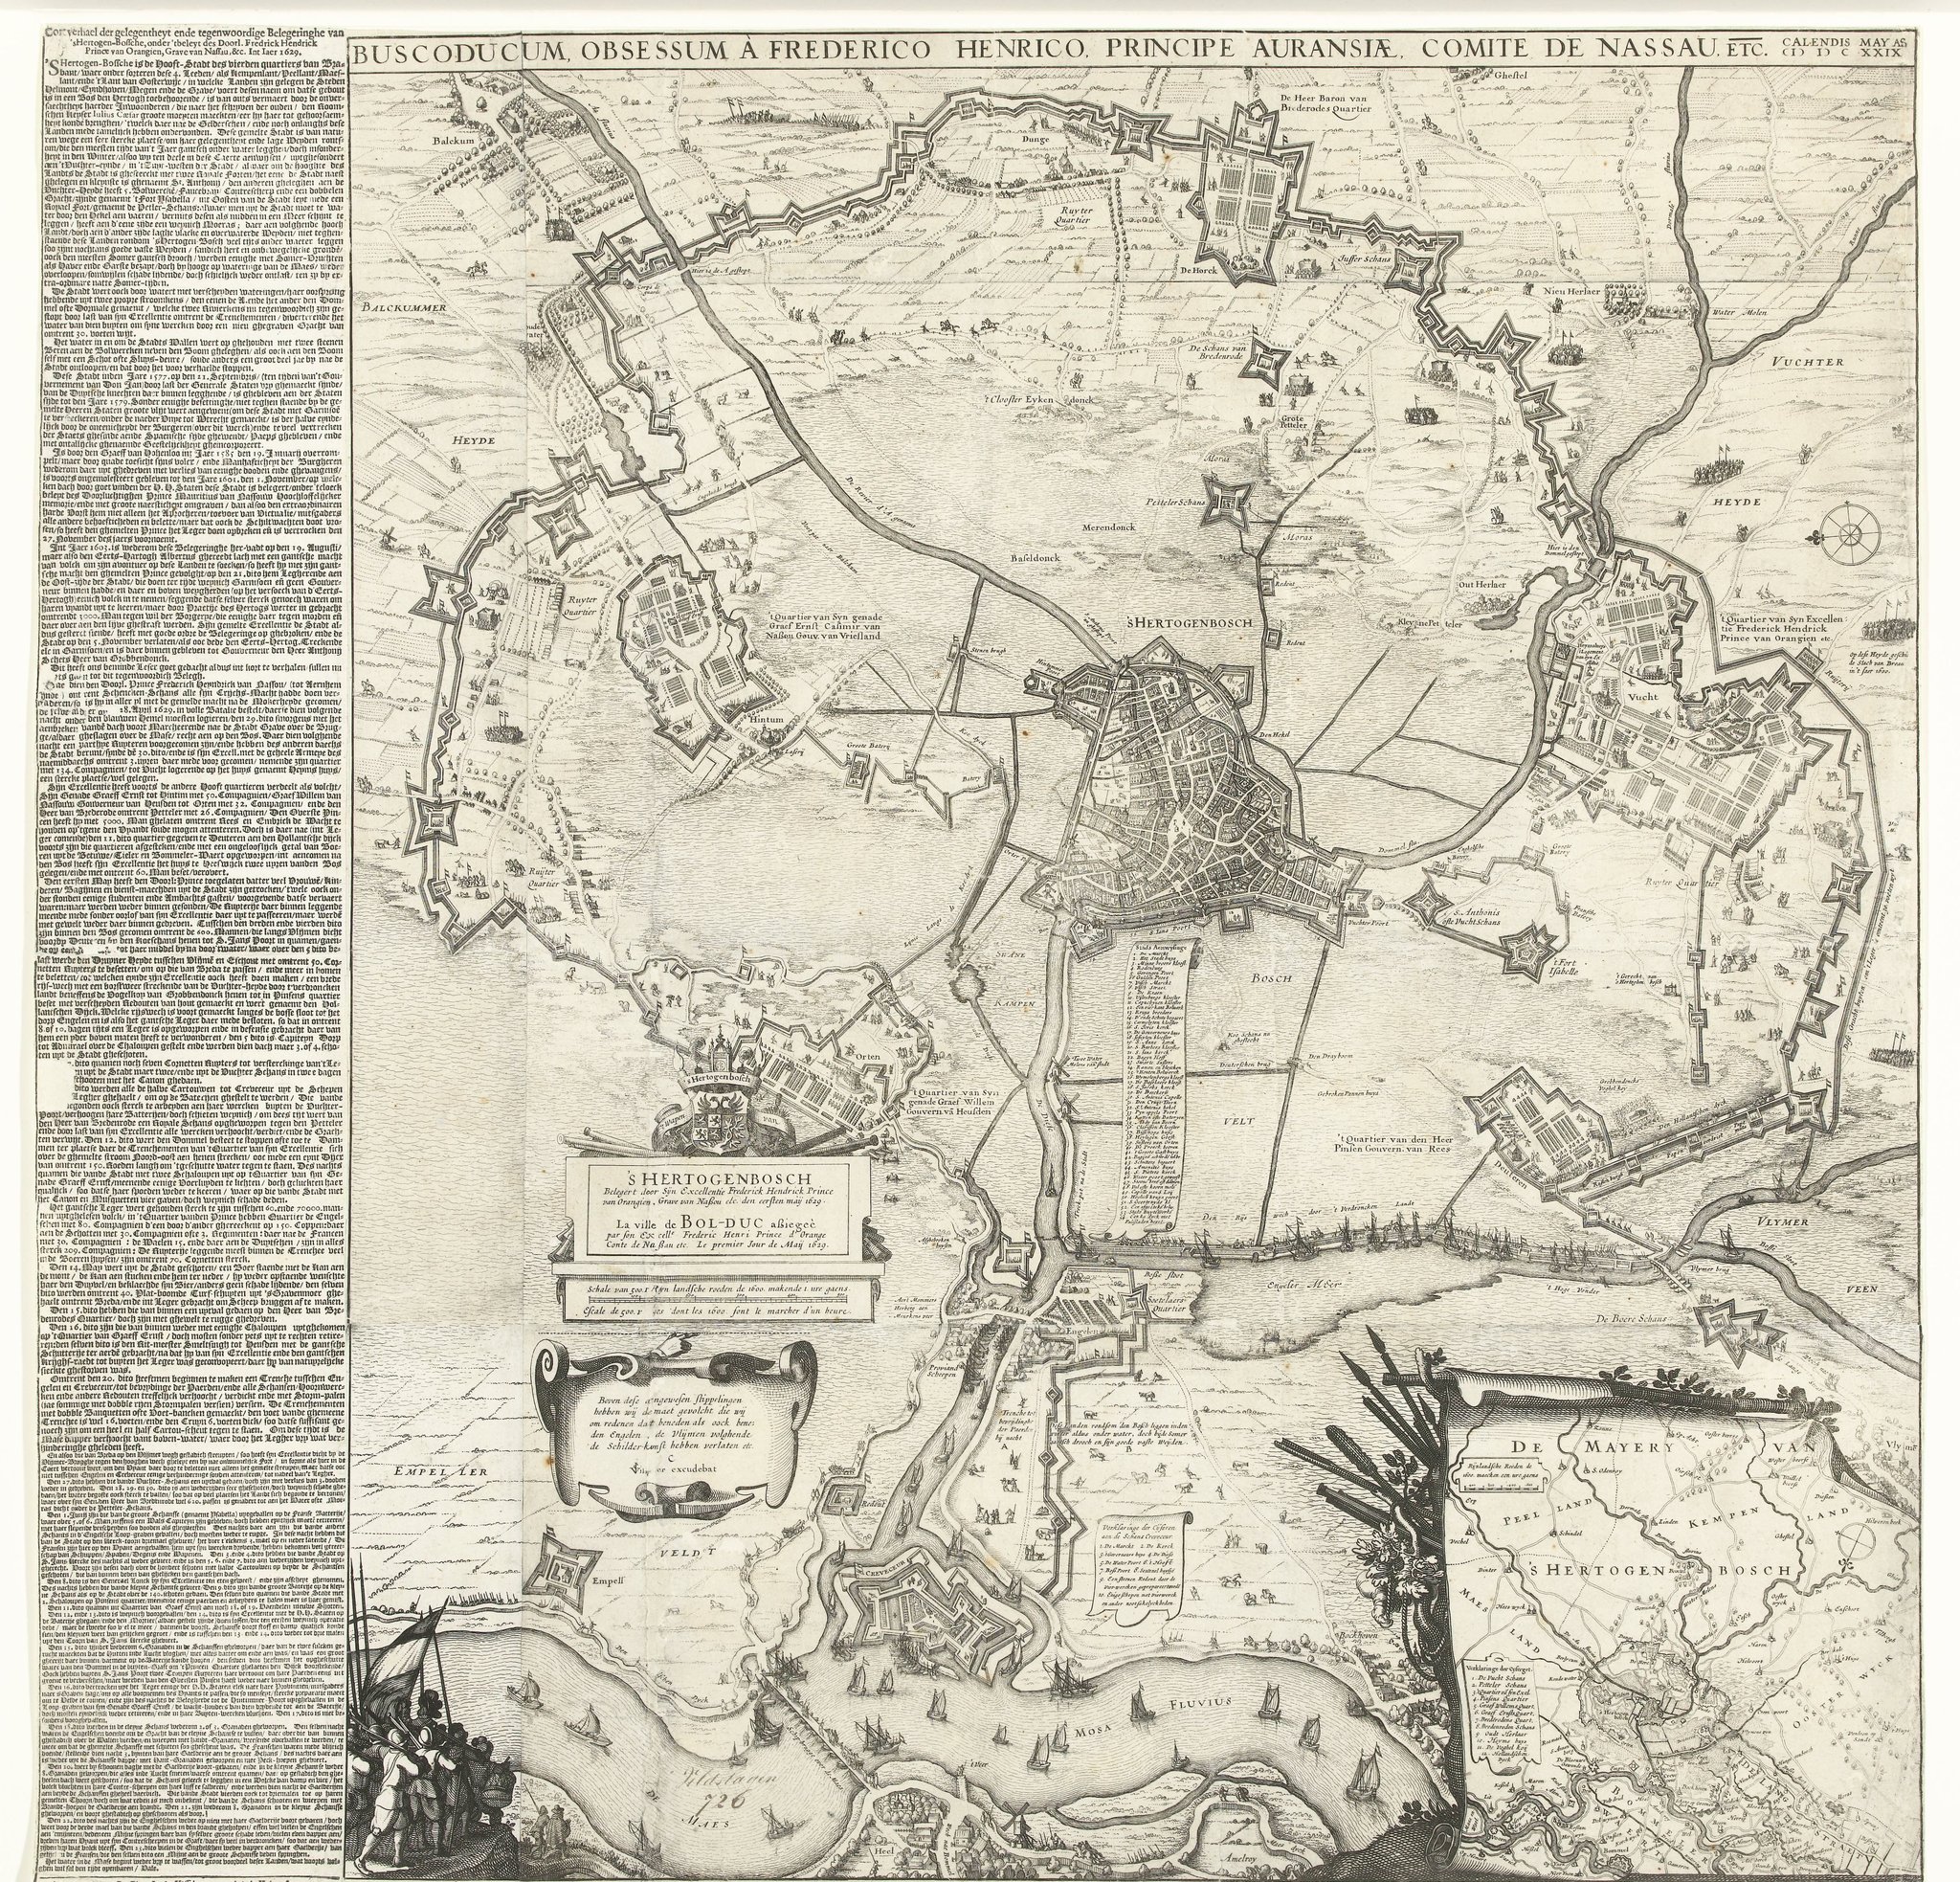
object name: print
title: Grote kaart van het beleg van Den Bosch door Frederik Hendrik, 1629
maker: claes jansz. visscher (ii)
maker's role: draughtsman, print maker, publisher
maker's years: 1586-1652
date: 1629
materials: paper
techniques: etching, letterpress printing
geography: amsterdam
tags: delft, frederick henry (prince of orange), maps of separate countries or regions, siege, position war, den bosch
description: Grote kaart van het beleg van Den Bosch door het Staatse leger onder Frederik Hendrik, van 1 mei tot 17 september 1629. Kaart met centraal de versterkte stad. Rechtsonder een inzet met een kaart van het groter geheel. Links een aangeplakte tekst met een beschrijving van de gebeurtenissen.